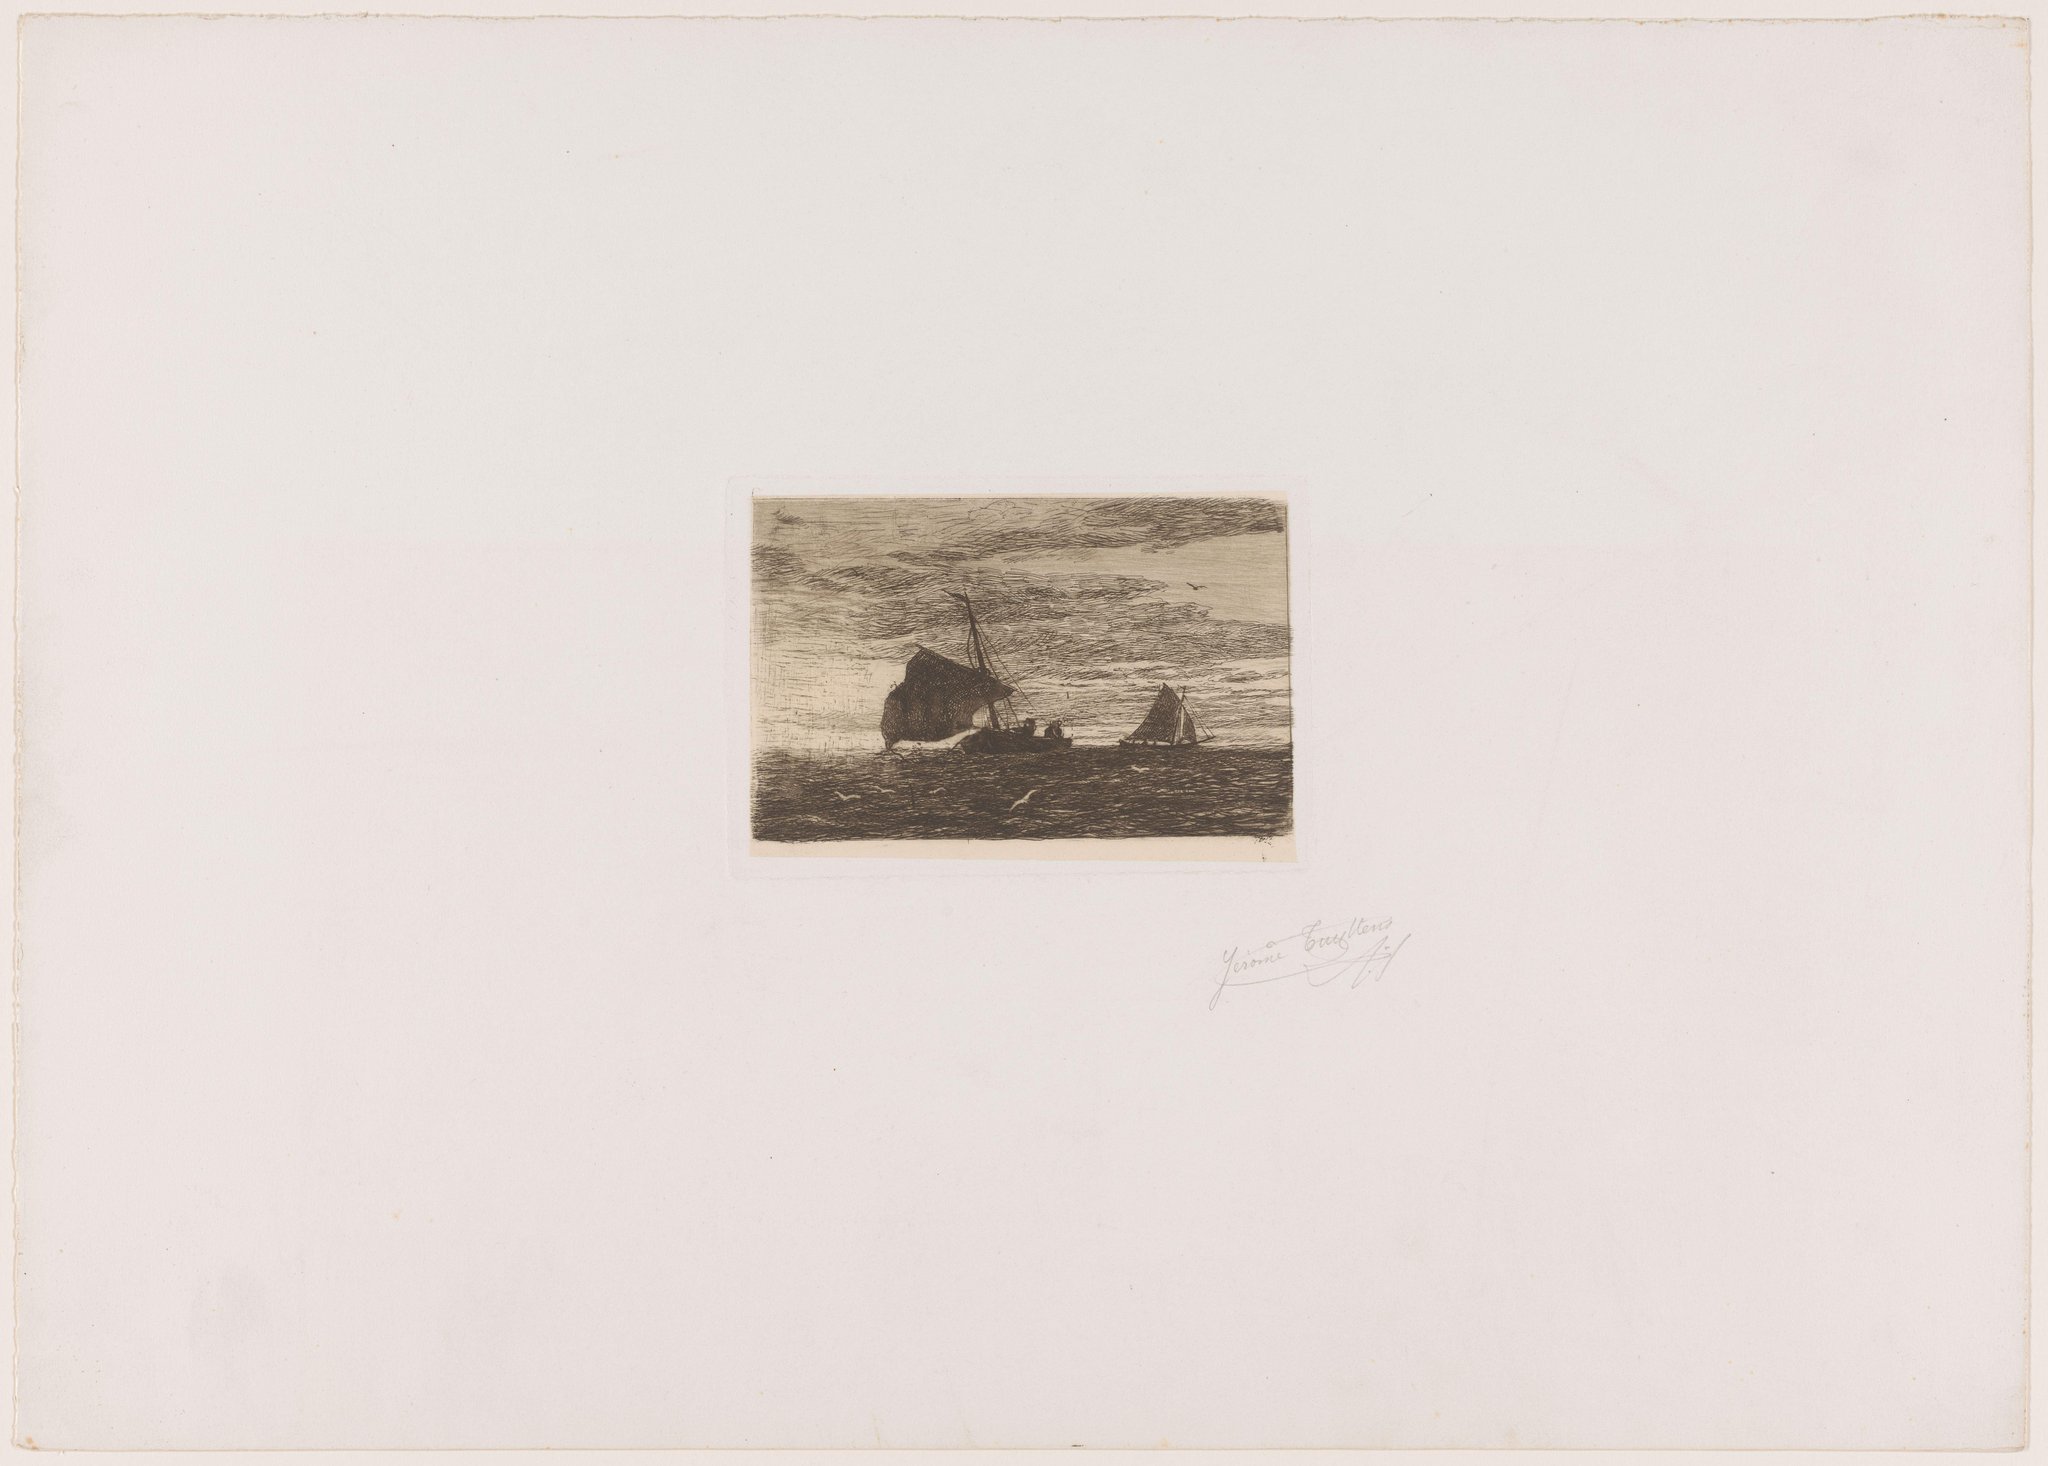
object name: print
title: Zeegezicht met twee zeilschepen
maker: jerôme tuyttens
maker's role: painter, print maker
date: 1850-1883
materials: paper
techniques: drypoint, etching, intaglio, retroussage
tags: sailing-ship, sailing-boat, sea (seascape)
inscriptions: collector's mark: Lugt 2228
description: Sterfdatum van de prentmaker is onbekend. Daarom is voor de bepaling van de rechten van dit object gebruik gemaakt van de verwervingsdatum Rijksmuseum Amsterdam.